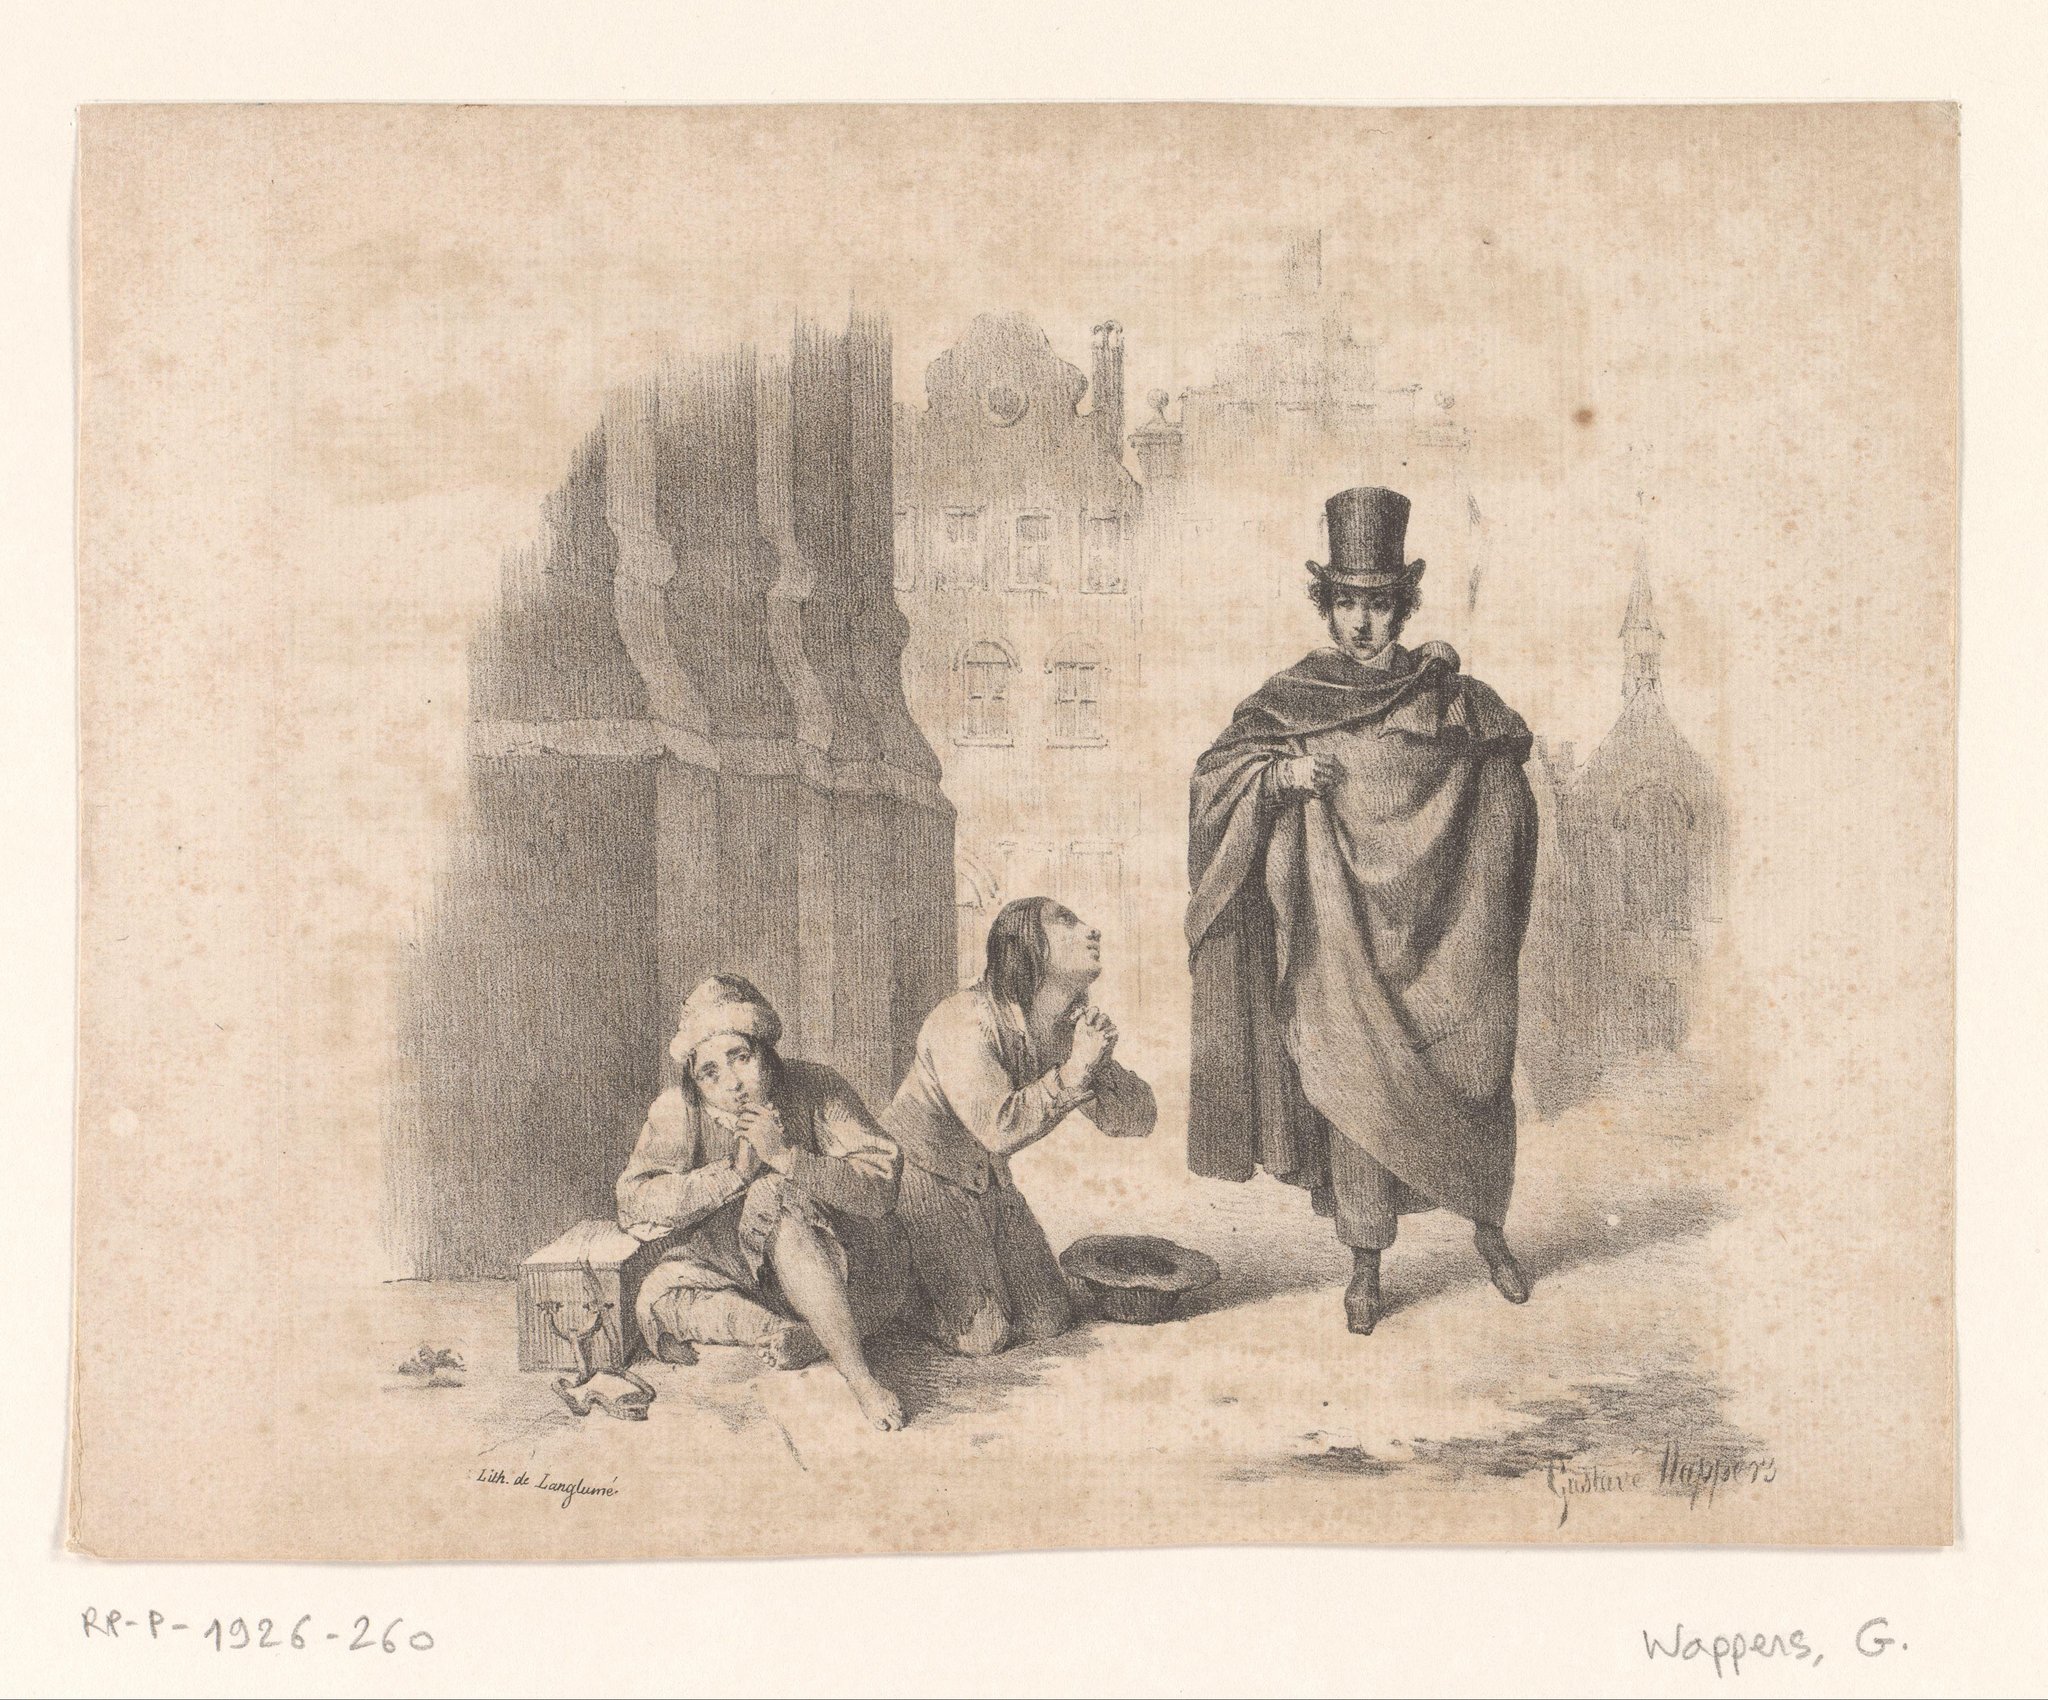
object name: print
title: Twee kinderen vragen om een aalmoes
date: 1813-1830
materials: paper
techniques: letterpress printing, lithograph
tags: giving alms or other charity, e.g.: handing out food